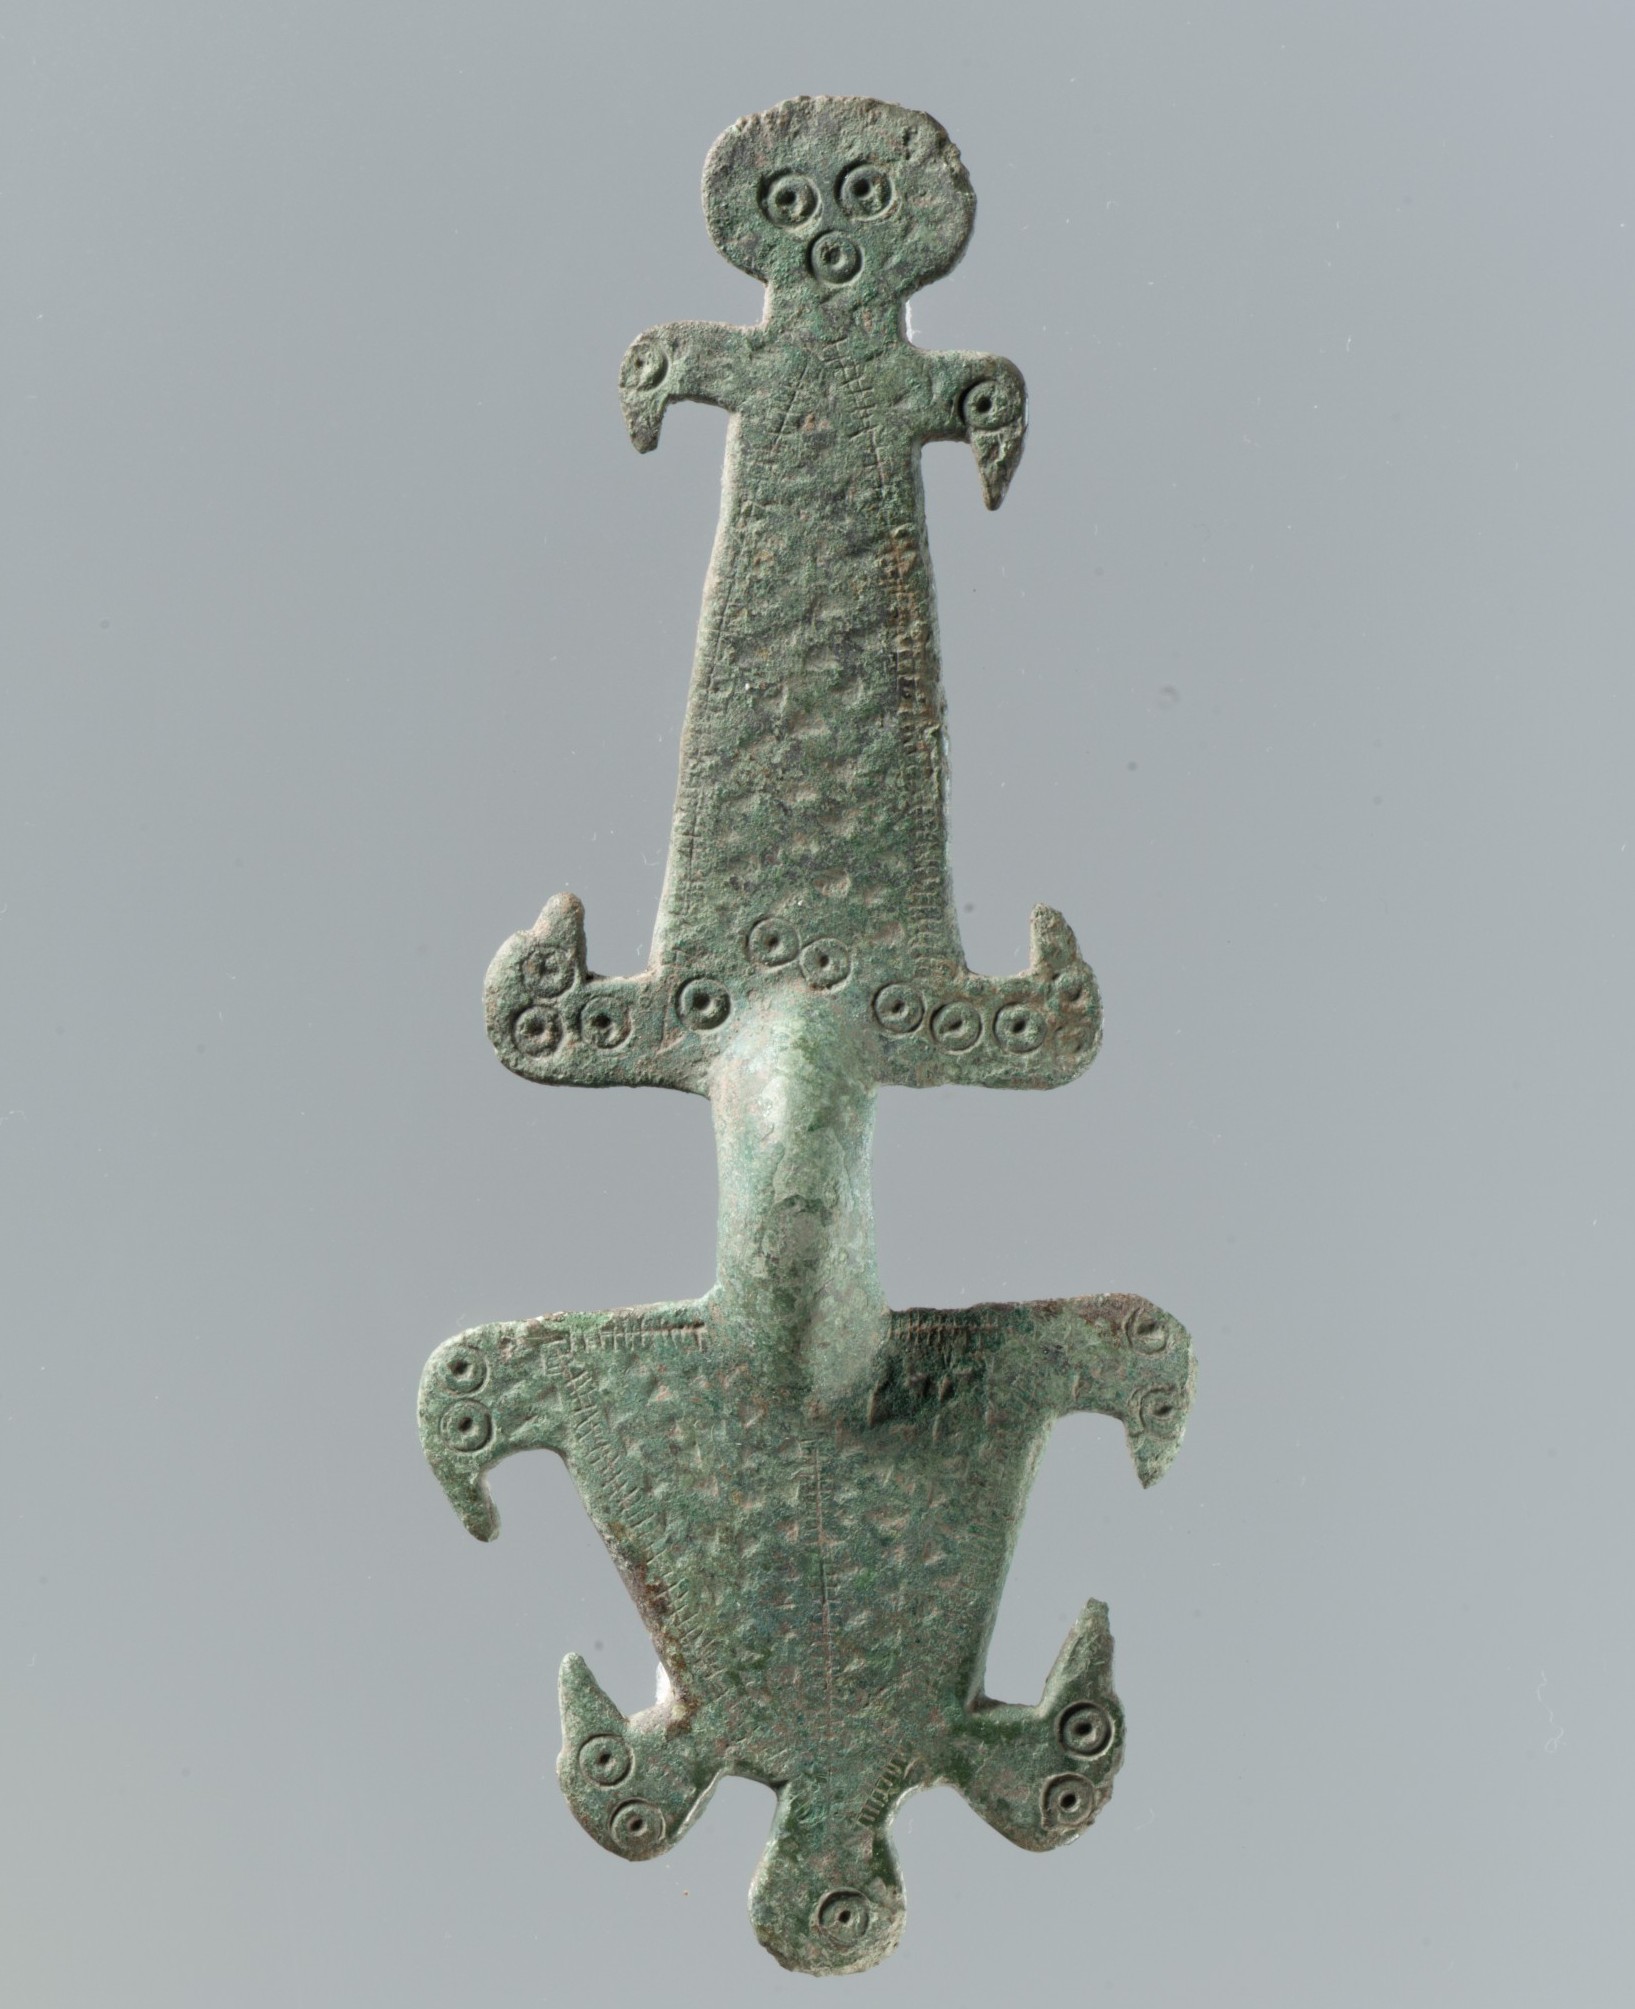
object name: brooch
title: Bow Brooch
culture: visigothic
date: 550-600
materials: copper alloy